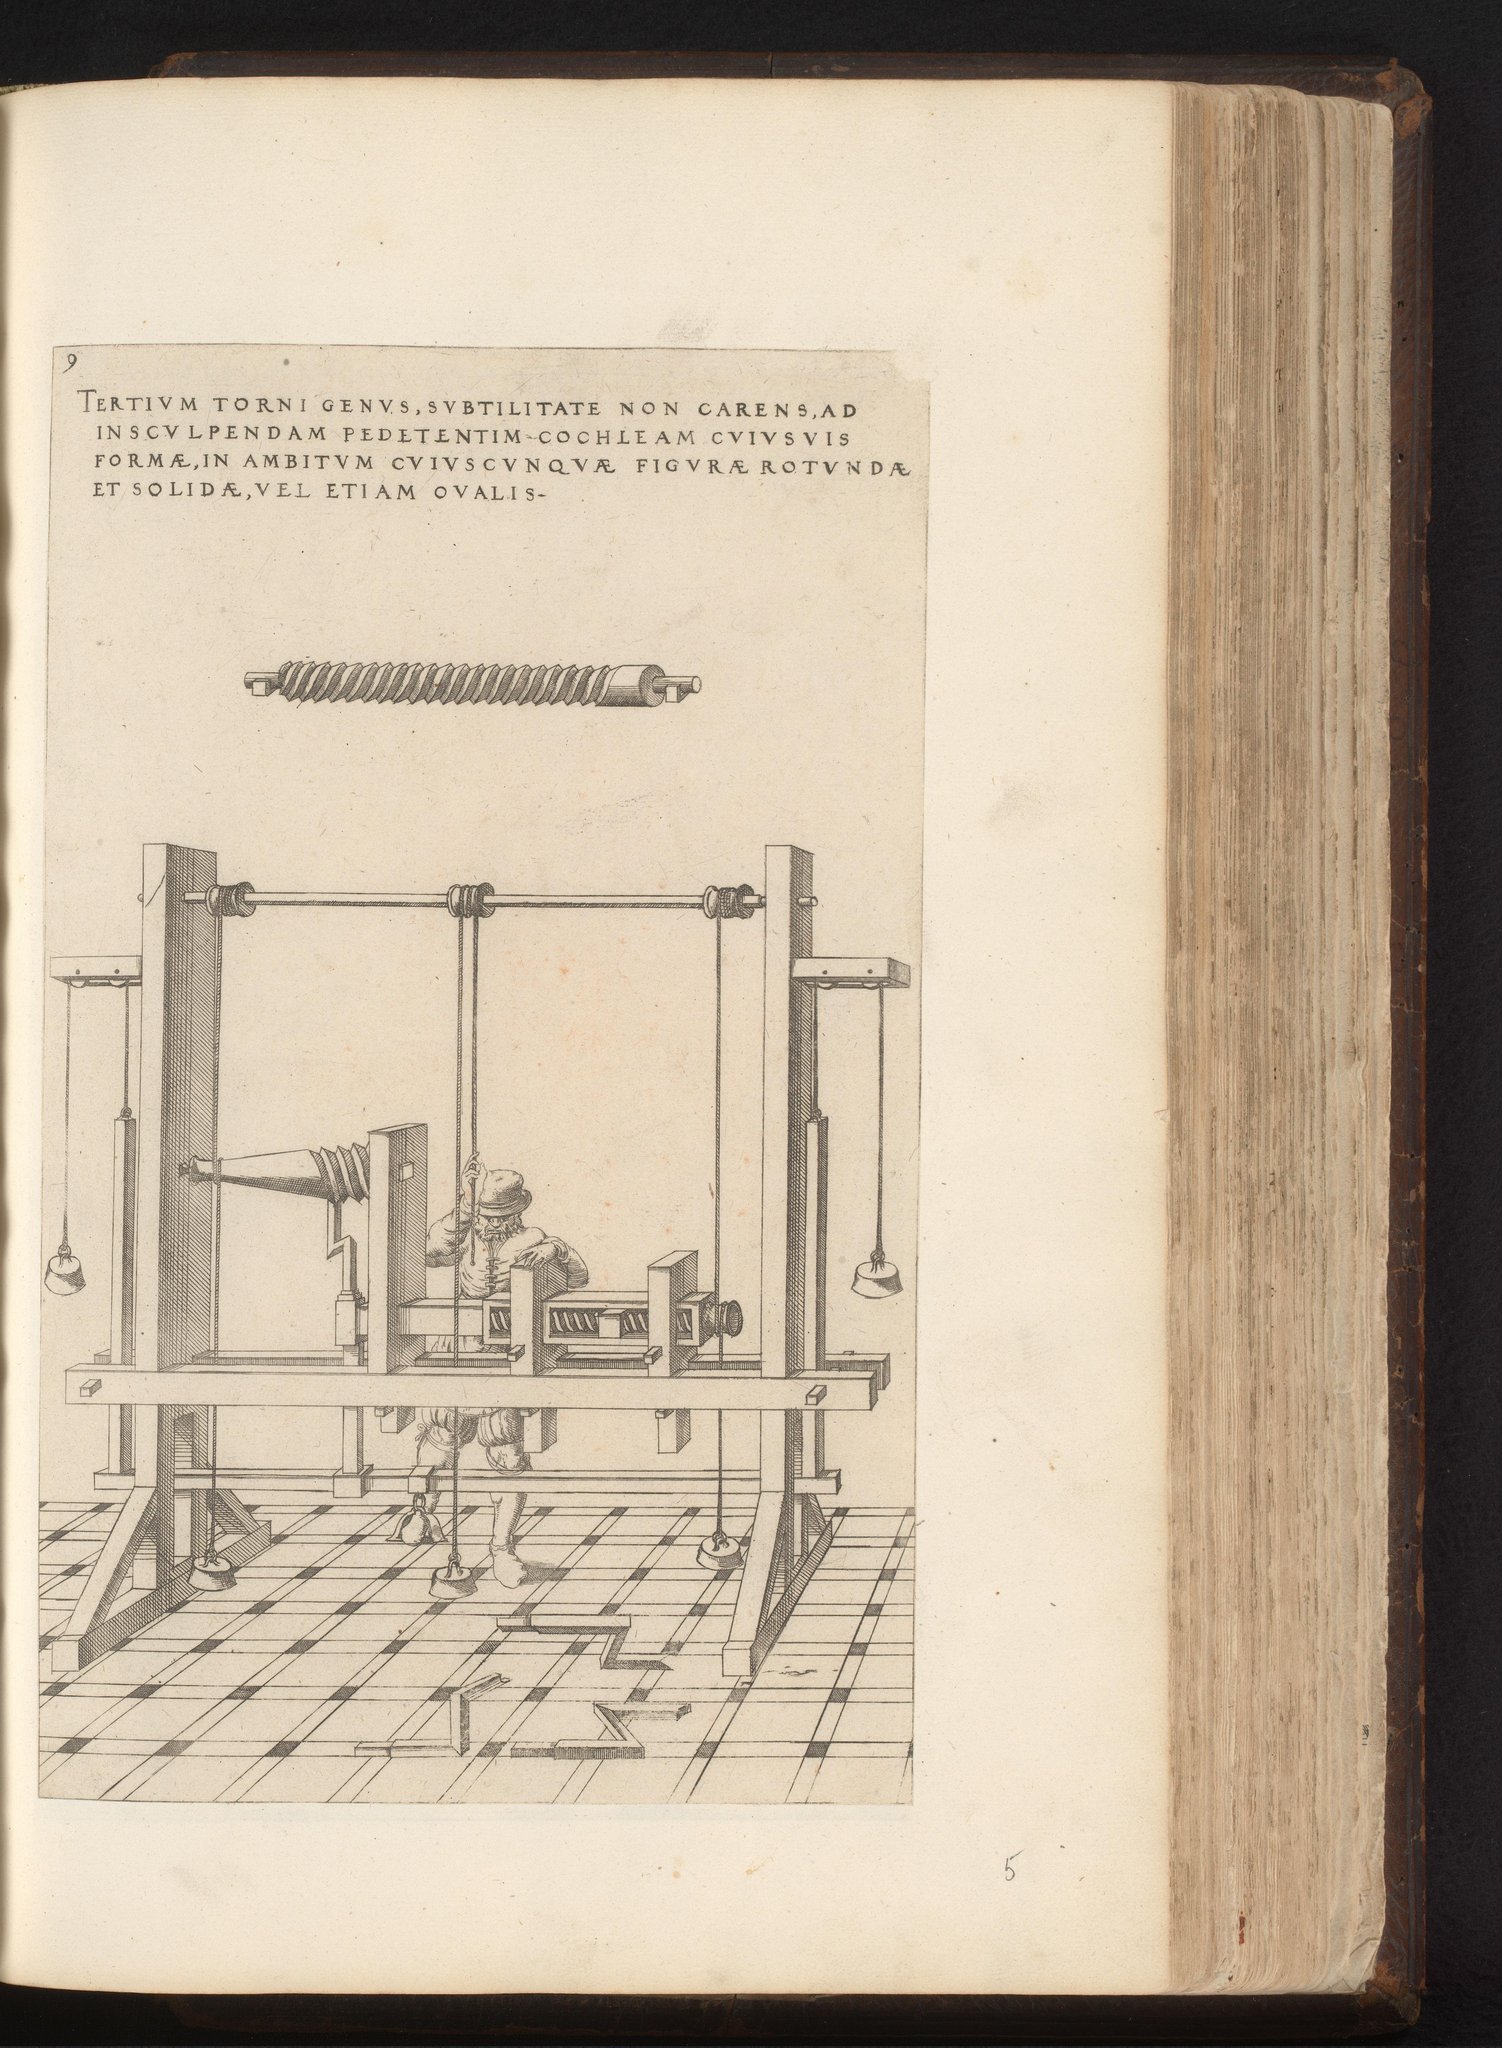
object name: print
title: Werker aan een draaibank voor het maken van schroeven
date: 1579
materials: paper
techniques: etching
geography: lyon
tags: turner in wood, handicrafts, craftsman at work, machines; parts of machines; tools and appliances, tools, aids, implements ~ crafts and industries: screw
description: Prent uit: Besson, Jacques. Theatre des instrumens mathematiques & mechaniques. Lyon: Barthelemy Vincent, 1579. Prent voor het eerst verschenen in de eerste editie van ca. 1569.